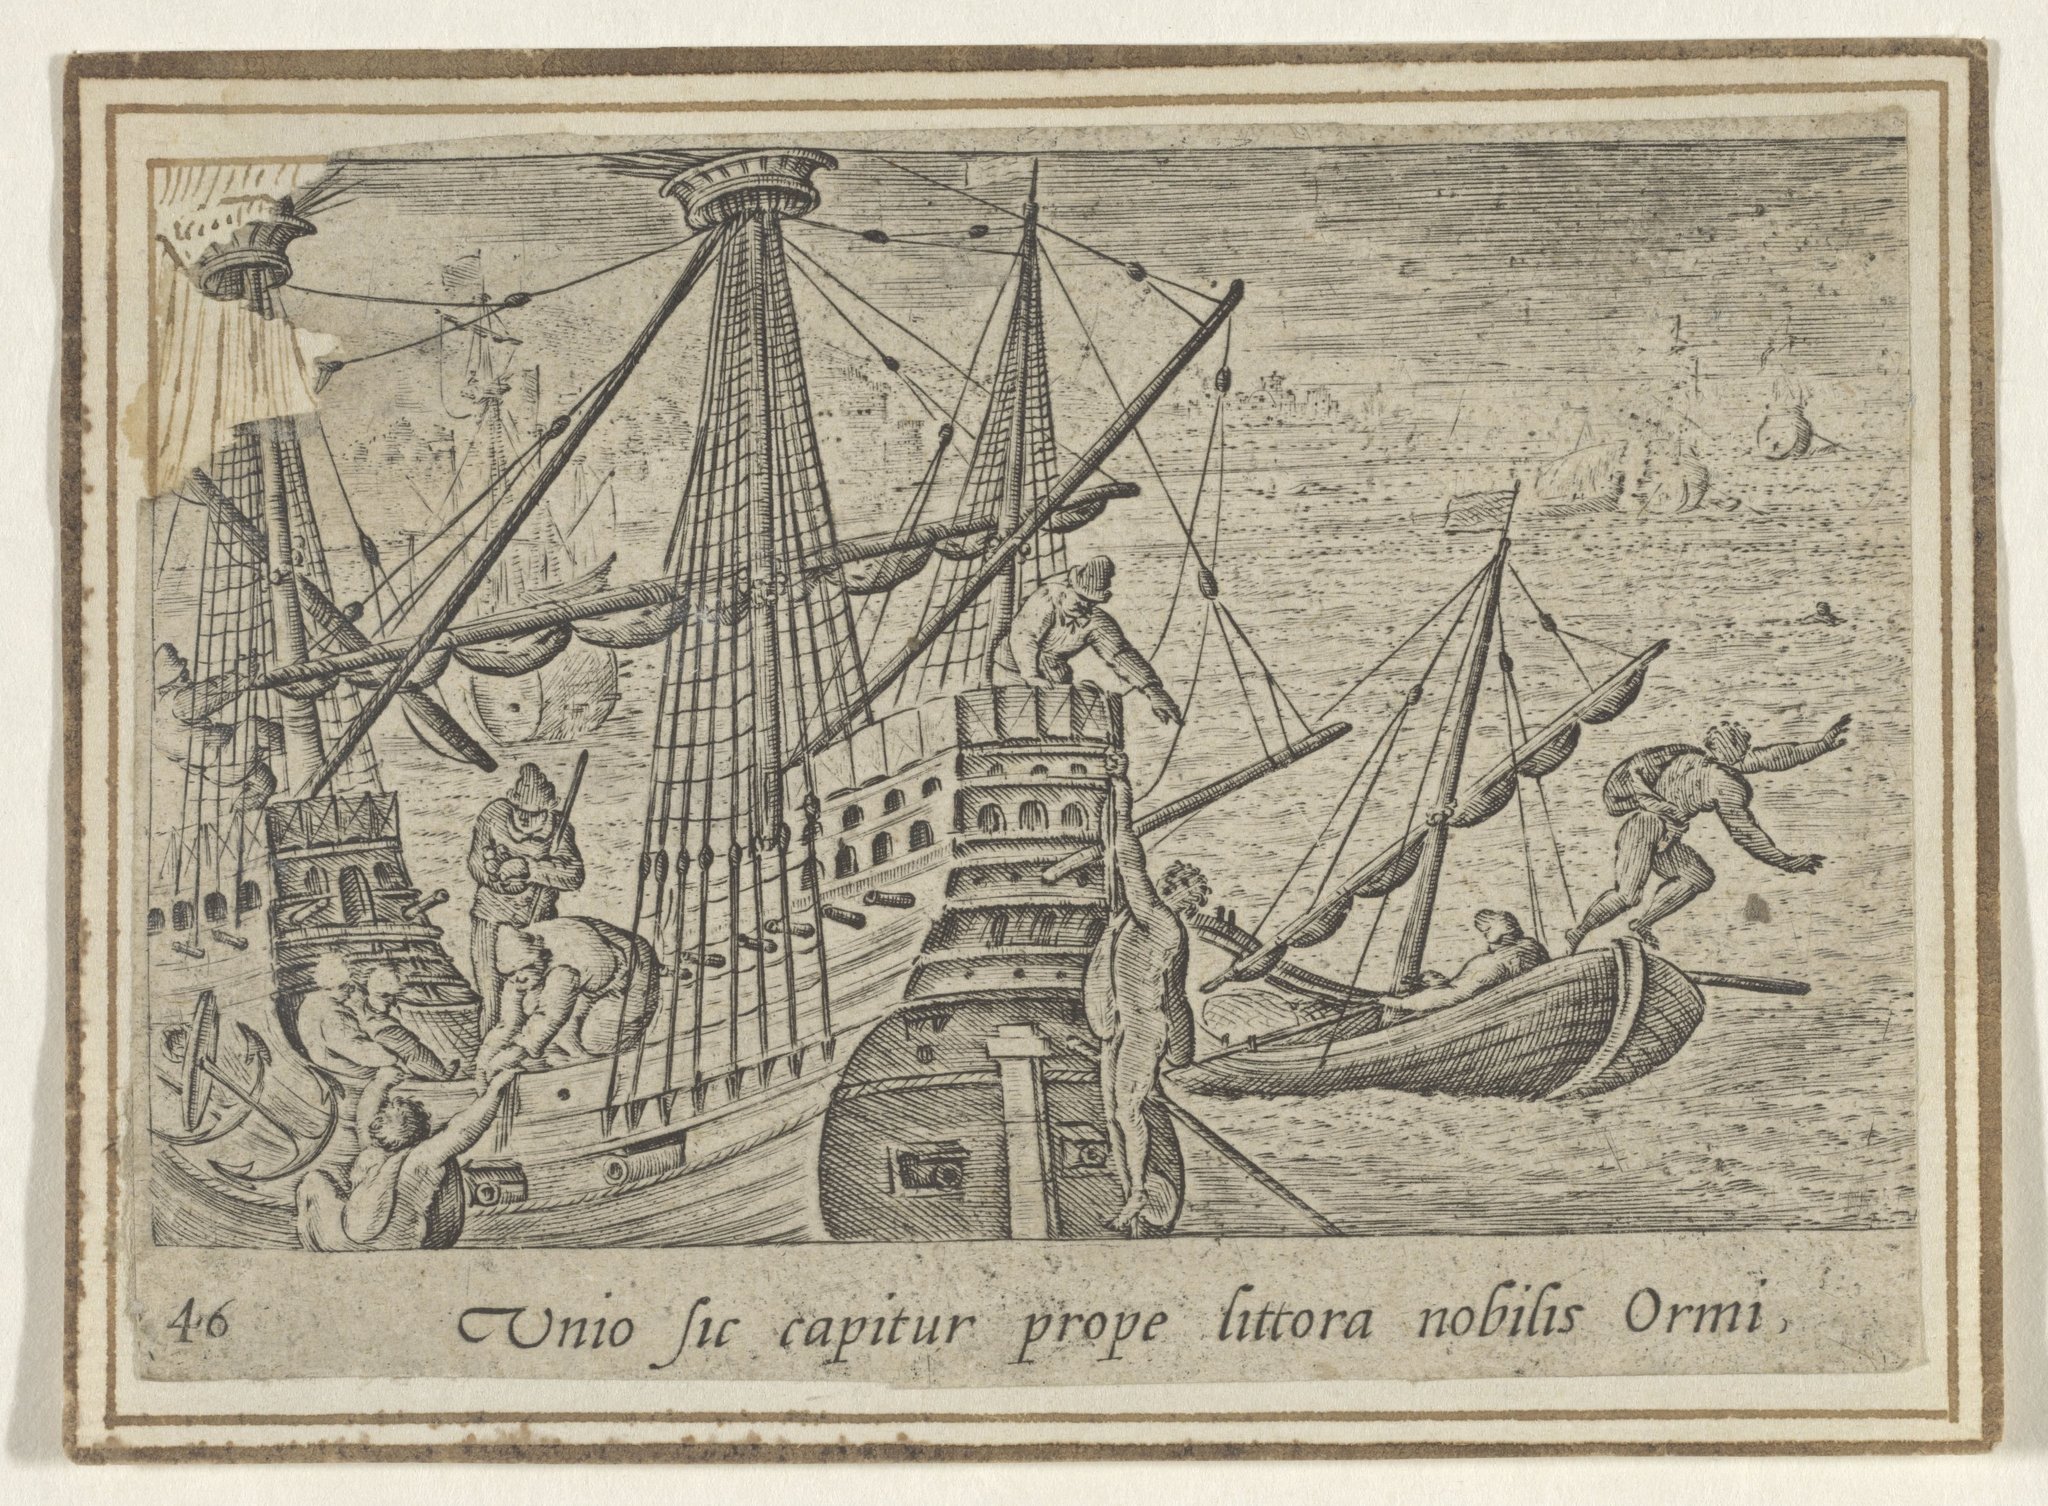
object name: print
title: Venationis, Piscationis, et Aucupii Typi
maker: adriaen collaert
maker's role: draughtsman, print maker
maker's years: 1560-1618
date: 1582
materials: paper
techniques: engraving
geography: southern netherlands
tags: ships (in general)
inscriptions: collector's mark: Lugt 2228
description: Gezicht op een zee met verscheidene schepen. Op de voorgrond een driemaster. Links wordt een figuur op de driemaster getrokken. Een regel Latijnse tekst in ondermarge. Genummerd linksonder: 46.